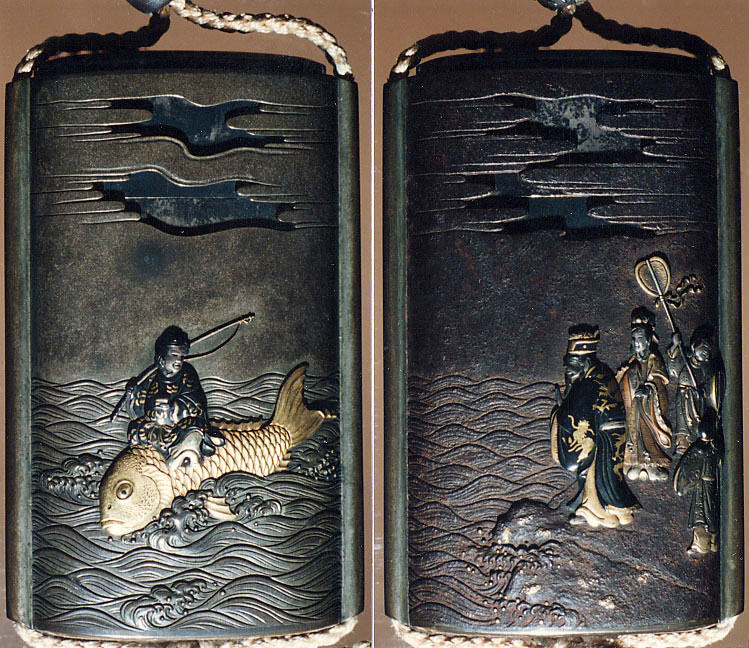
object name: inrō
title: Case (Inrō) with Design of Urashima Tarō Riding a Fish among Waves (obverse); Dragon King and His Daughter on Shore (reverse)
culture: japanese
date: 1801-1900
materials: metal, silver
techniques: incising, relief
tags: men,women,fish,waves